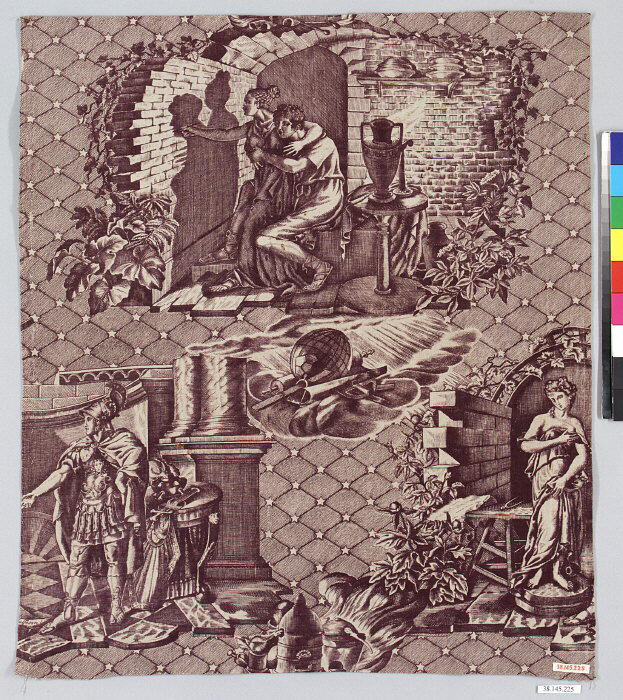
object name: piece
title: "The Arts"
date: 1801-1833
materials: cotton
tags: soldiers,men,women,leaves